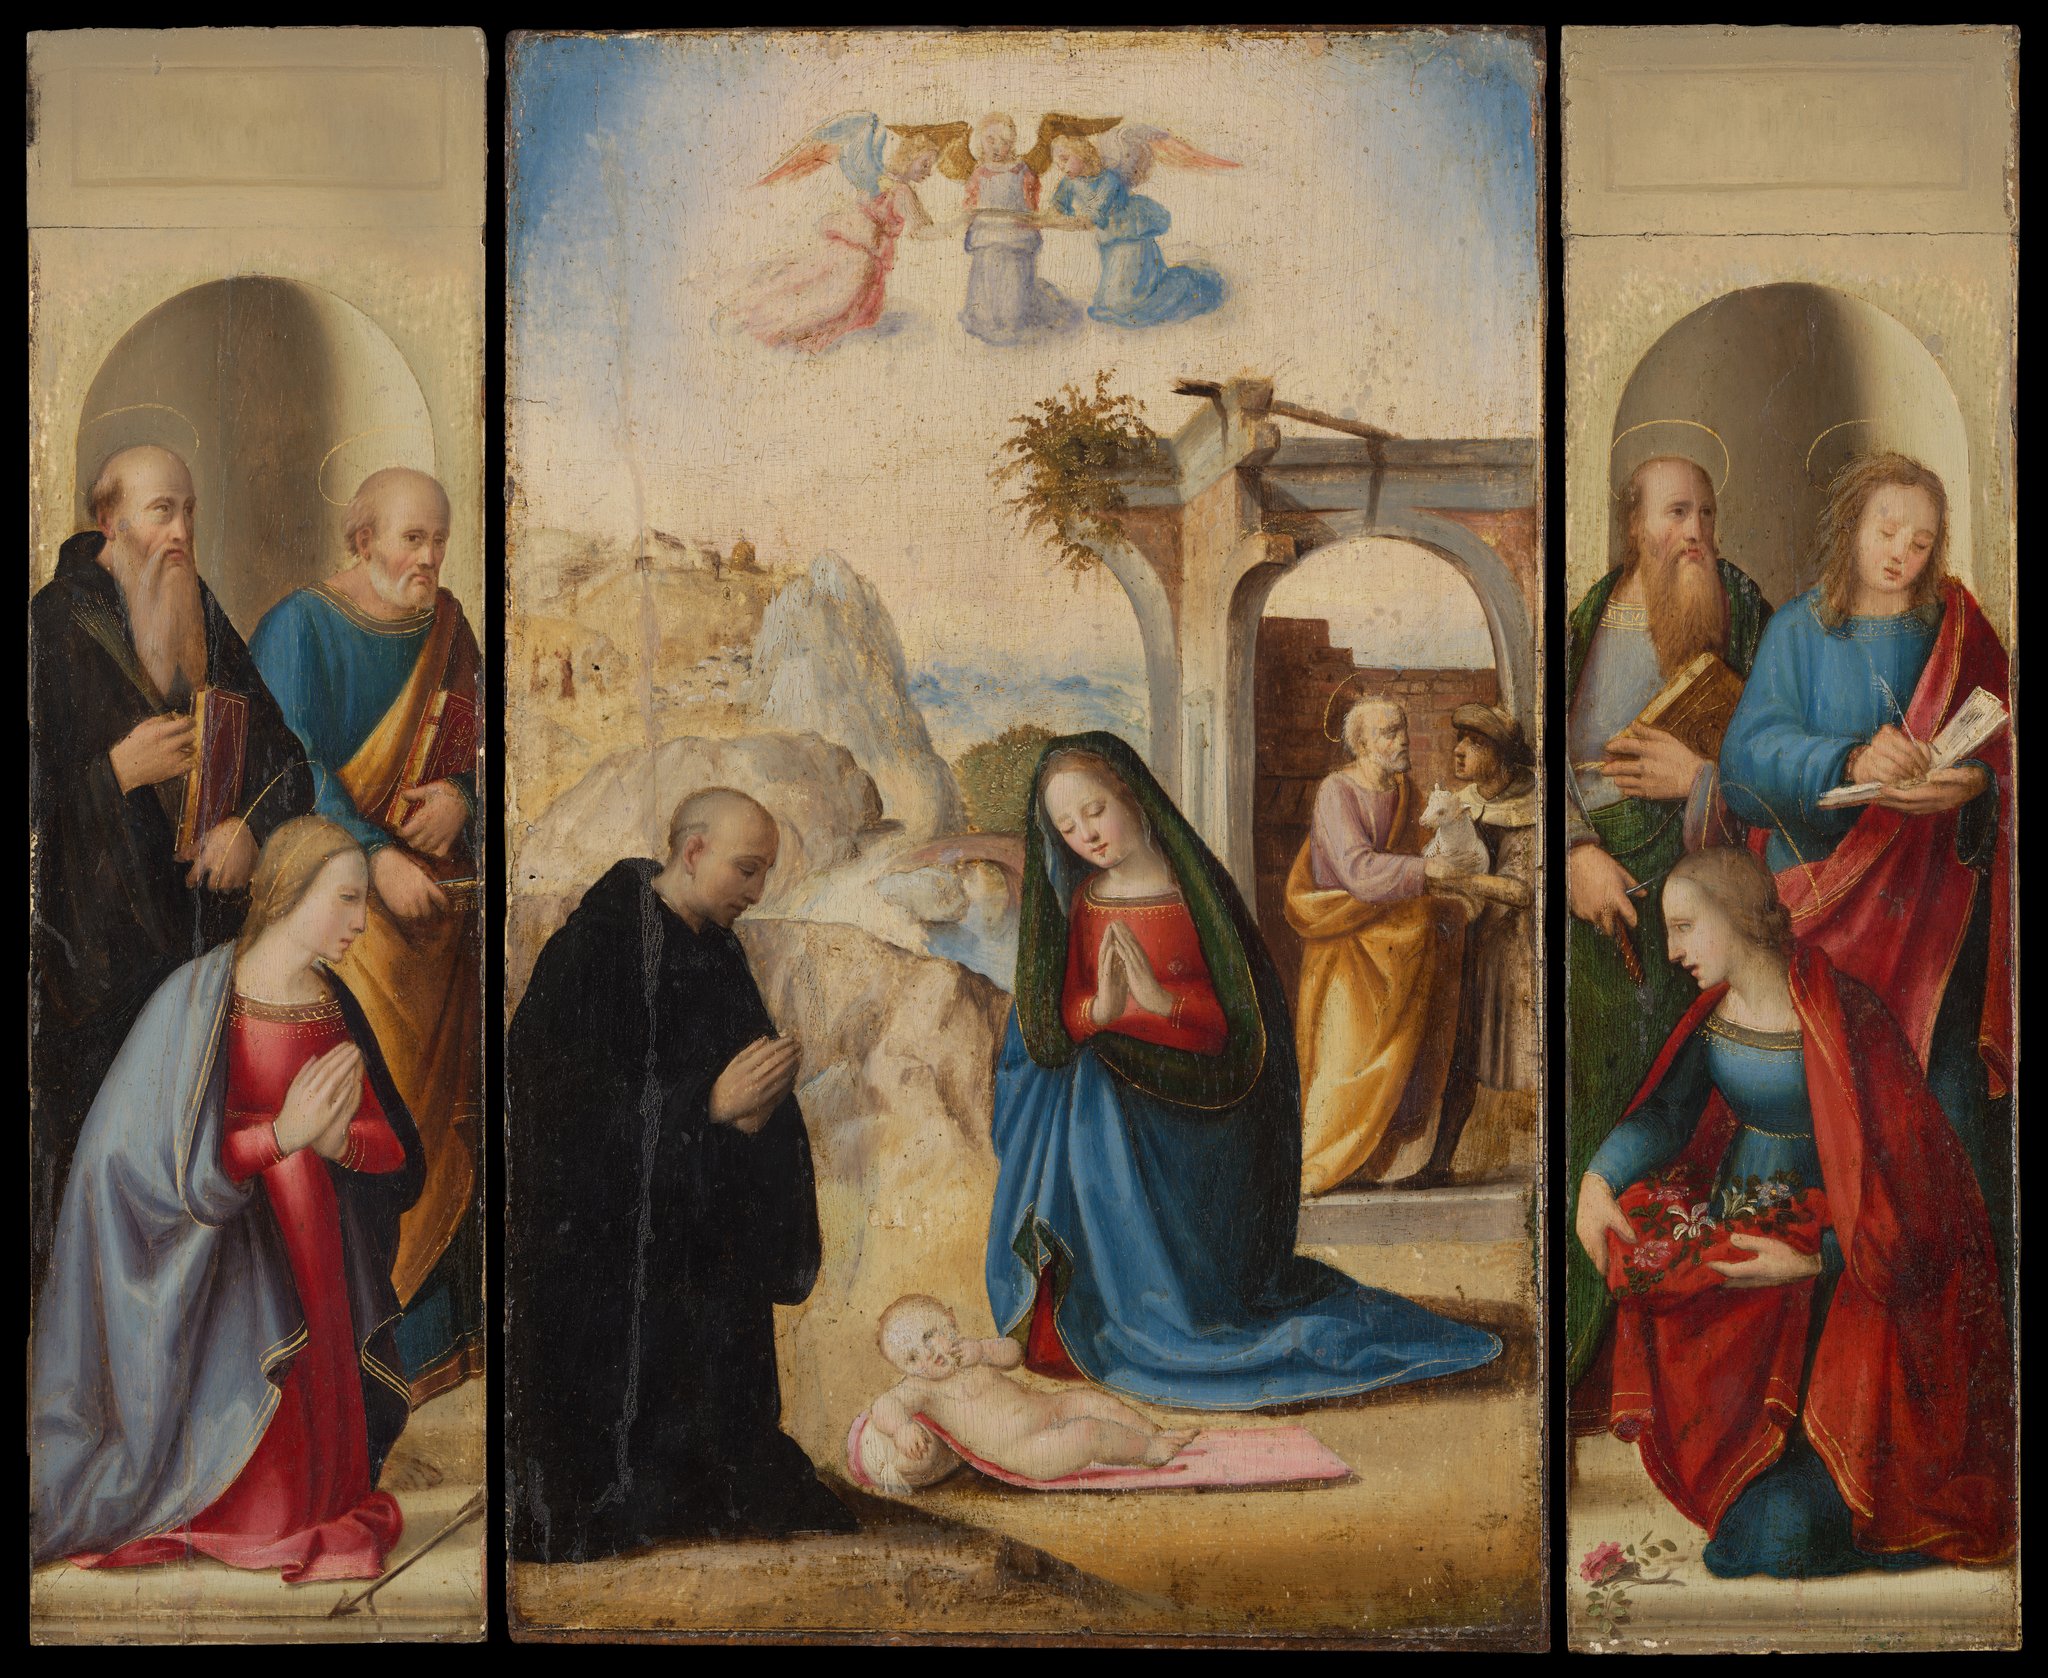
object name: painting, triptych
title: The Nativity with Saints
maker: ridolfo ghirlandaio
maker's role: artist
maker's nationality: italian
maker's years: 1483-1561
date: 1503-1561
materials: oil, wood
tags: men,angels,madonna and child,saint john the evangelist,saint paul,saint peter,nativity,saints